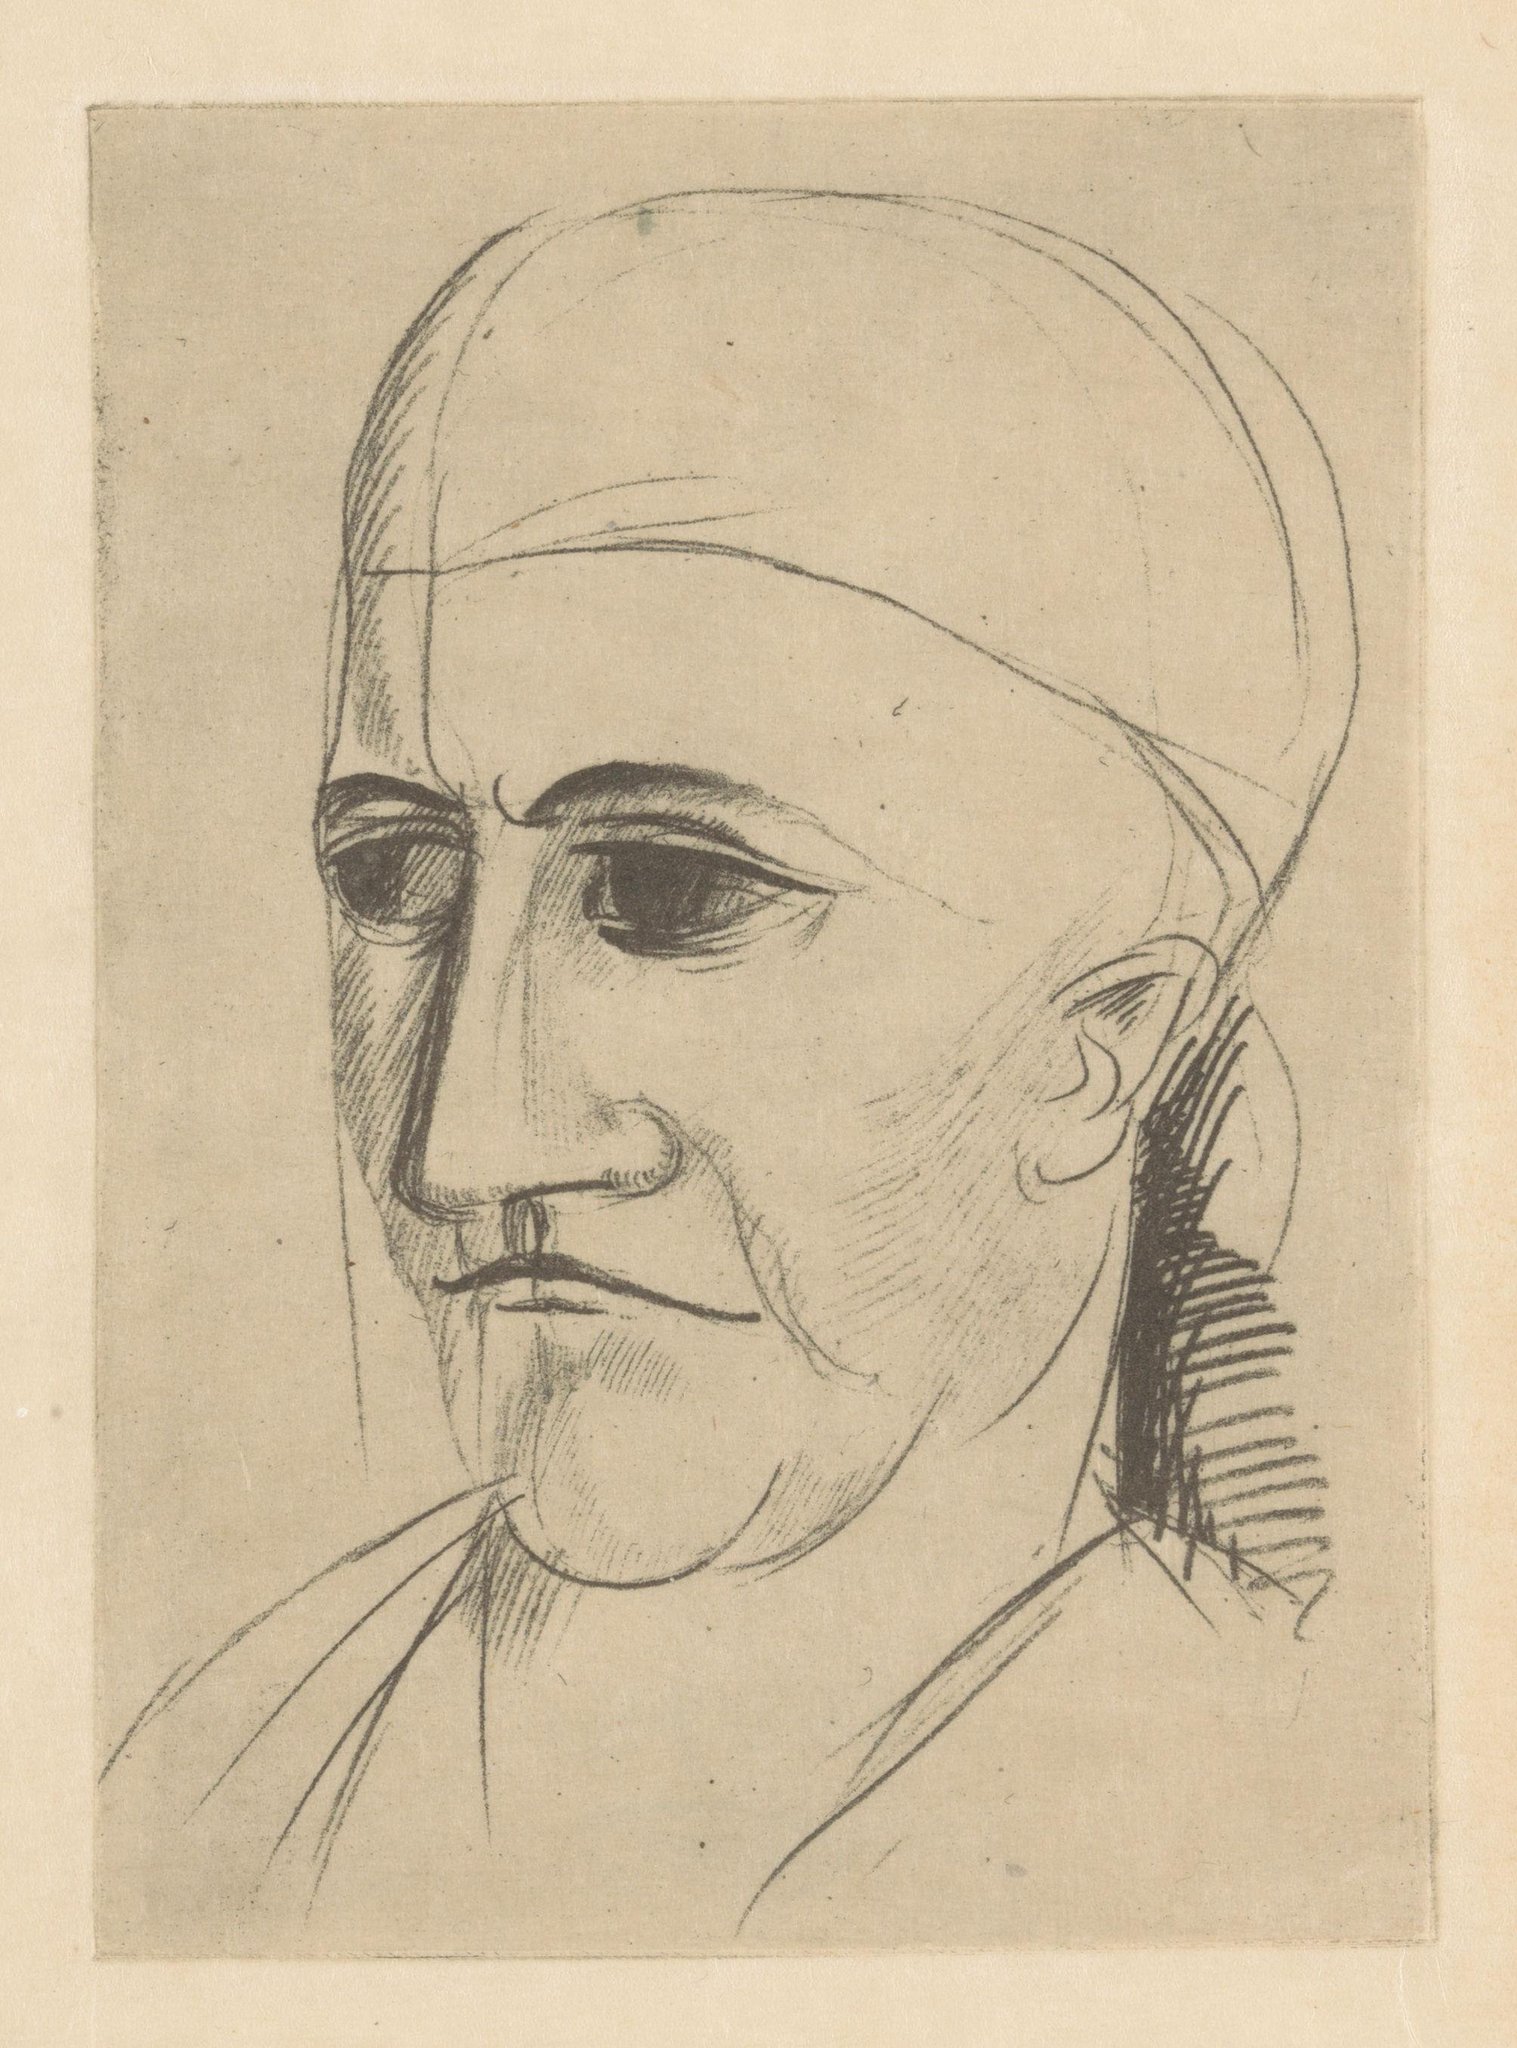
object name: print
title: Studie van een mannenhoofd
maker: marius holleman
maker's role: draughtsman, print maker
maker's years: 1878-1926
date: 1904-1926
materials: paper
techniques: etching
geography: groningen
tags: baldness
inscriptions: collector's mark: Lugt 2228